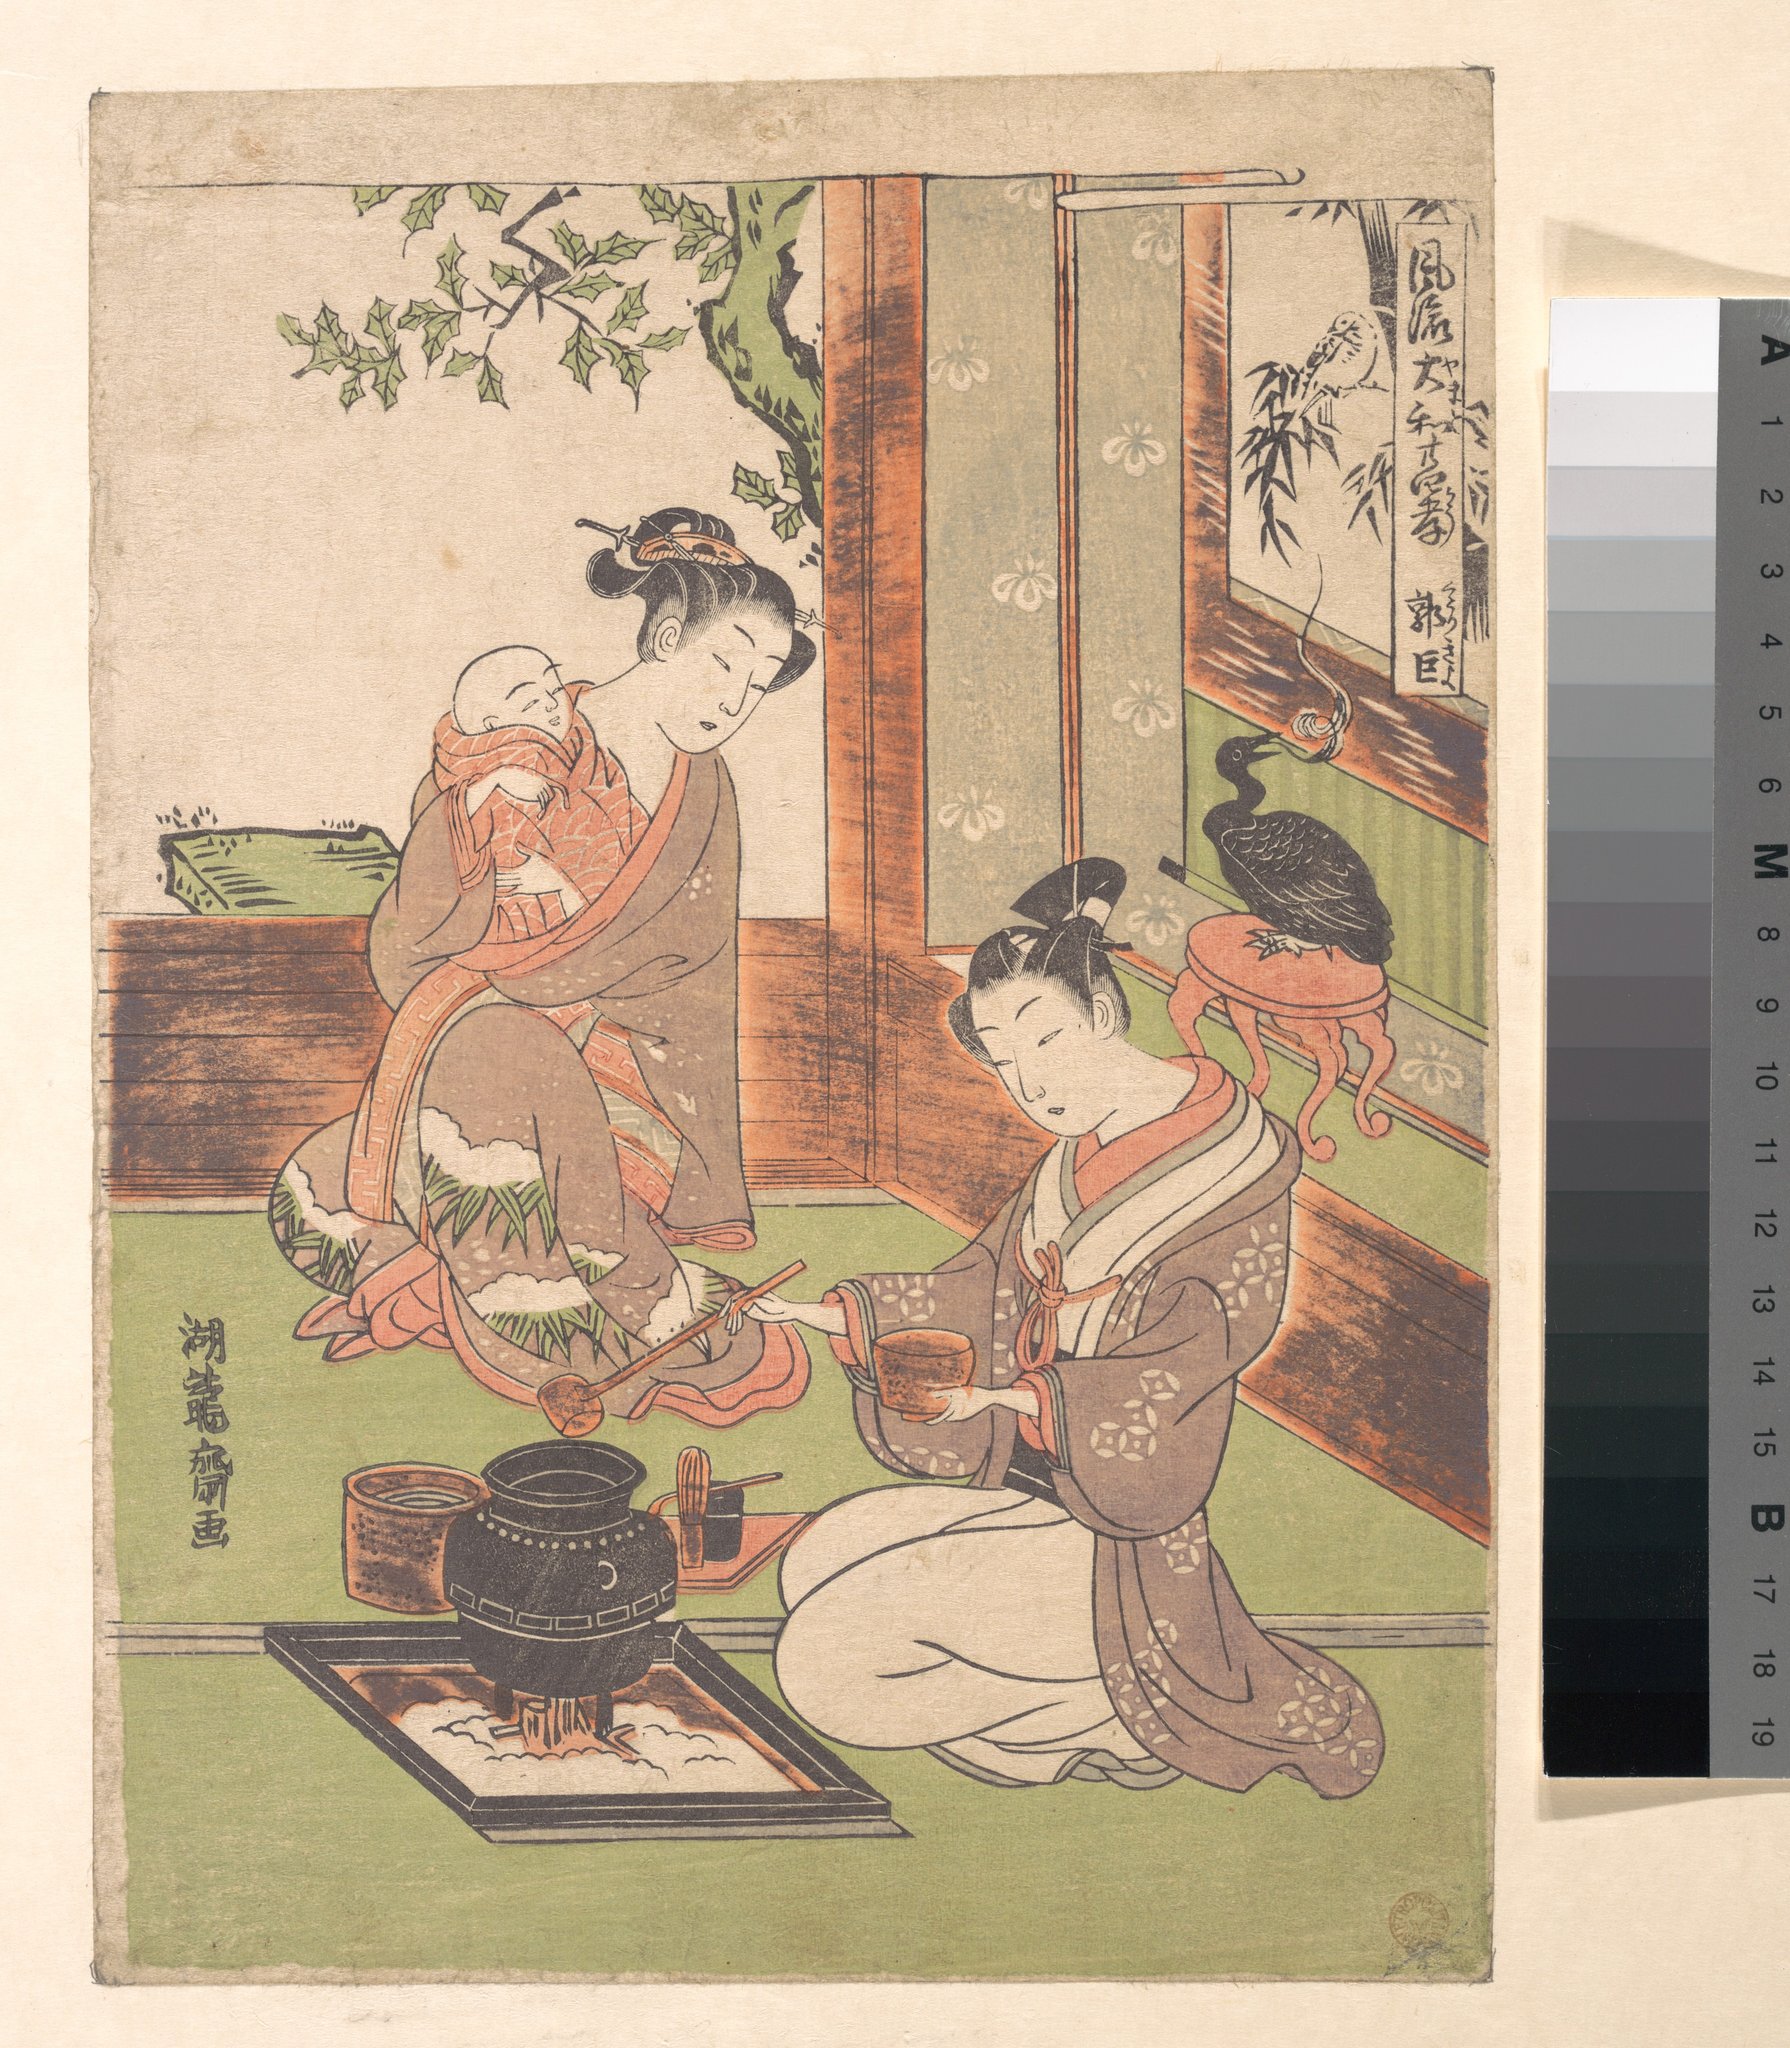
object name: print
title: Modern Versions of the twenty-four Paragons of Filial Piety: Guo Zhu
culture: japanese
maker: isoda koryūsai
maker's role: artist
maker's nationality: japanese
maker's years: 1735-1790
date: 1770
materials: ink, paper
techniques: woodblock print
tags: birds,infants,men,women,cauldrons